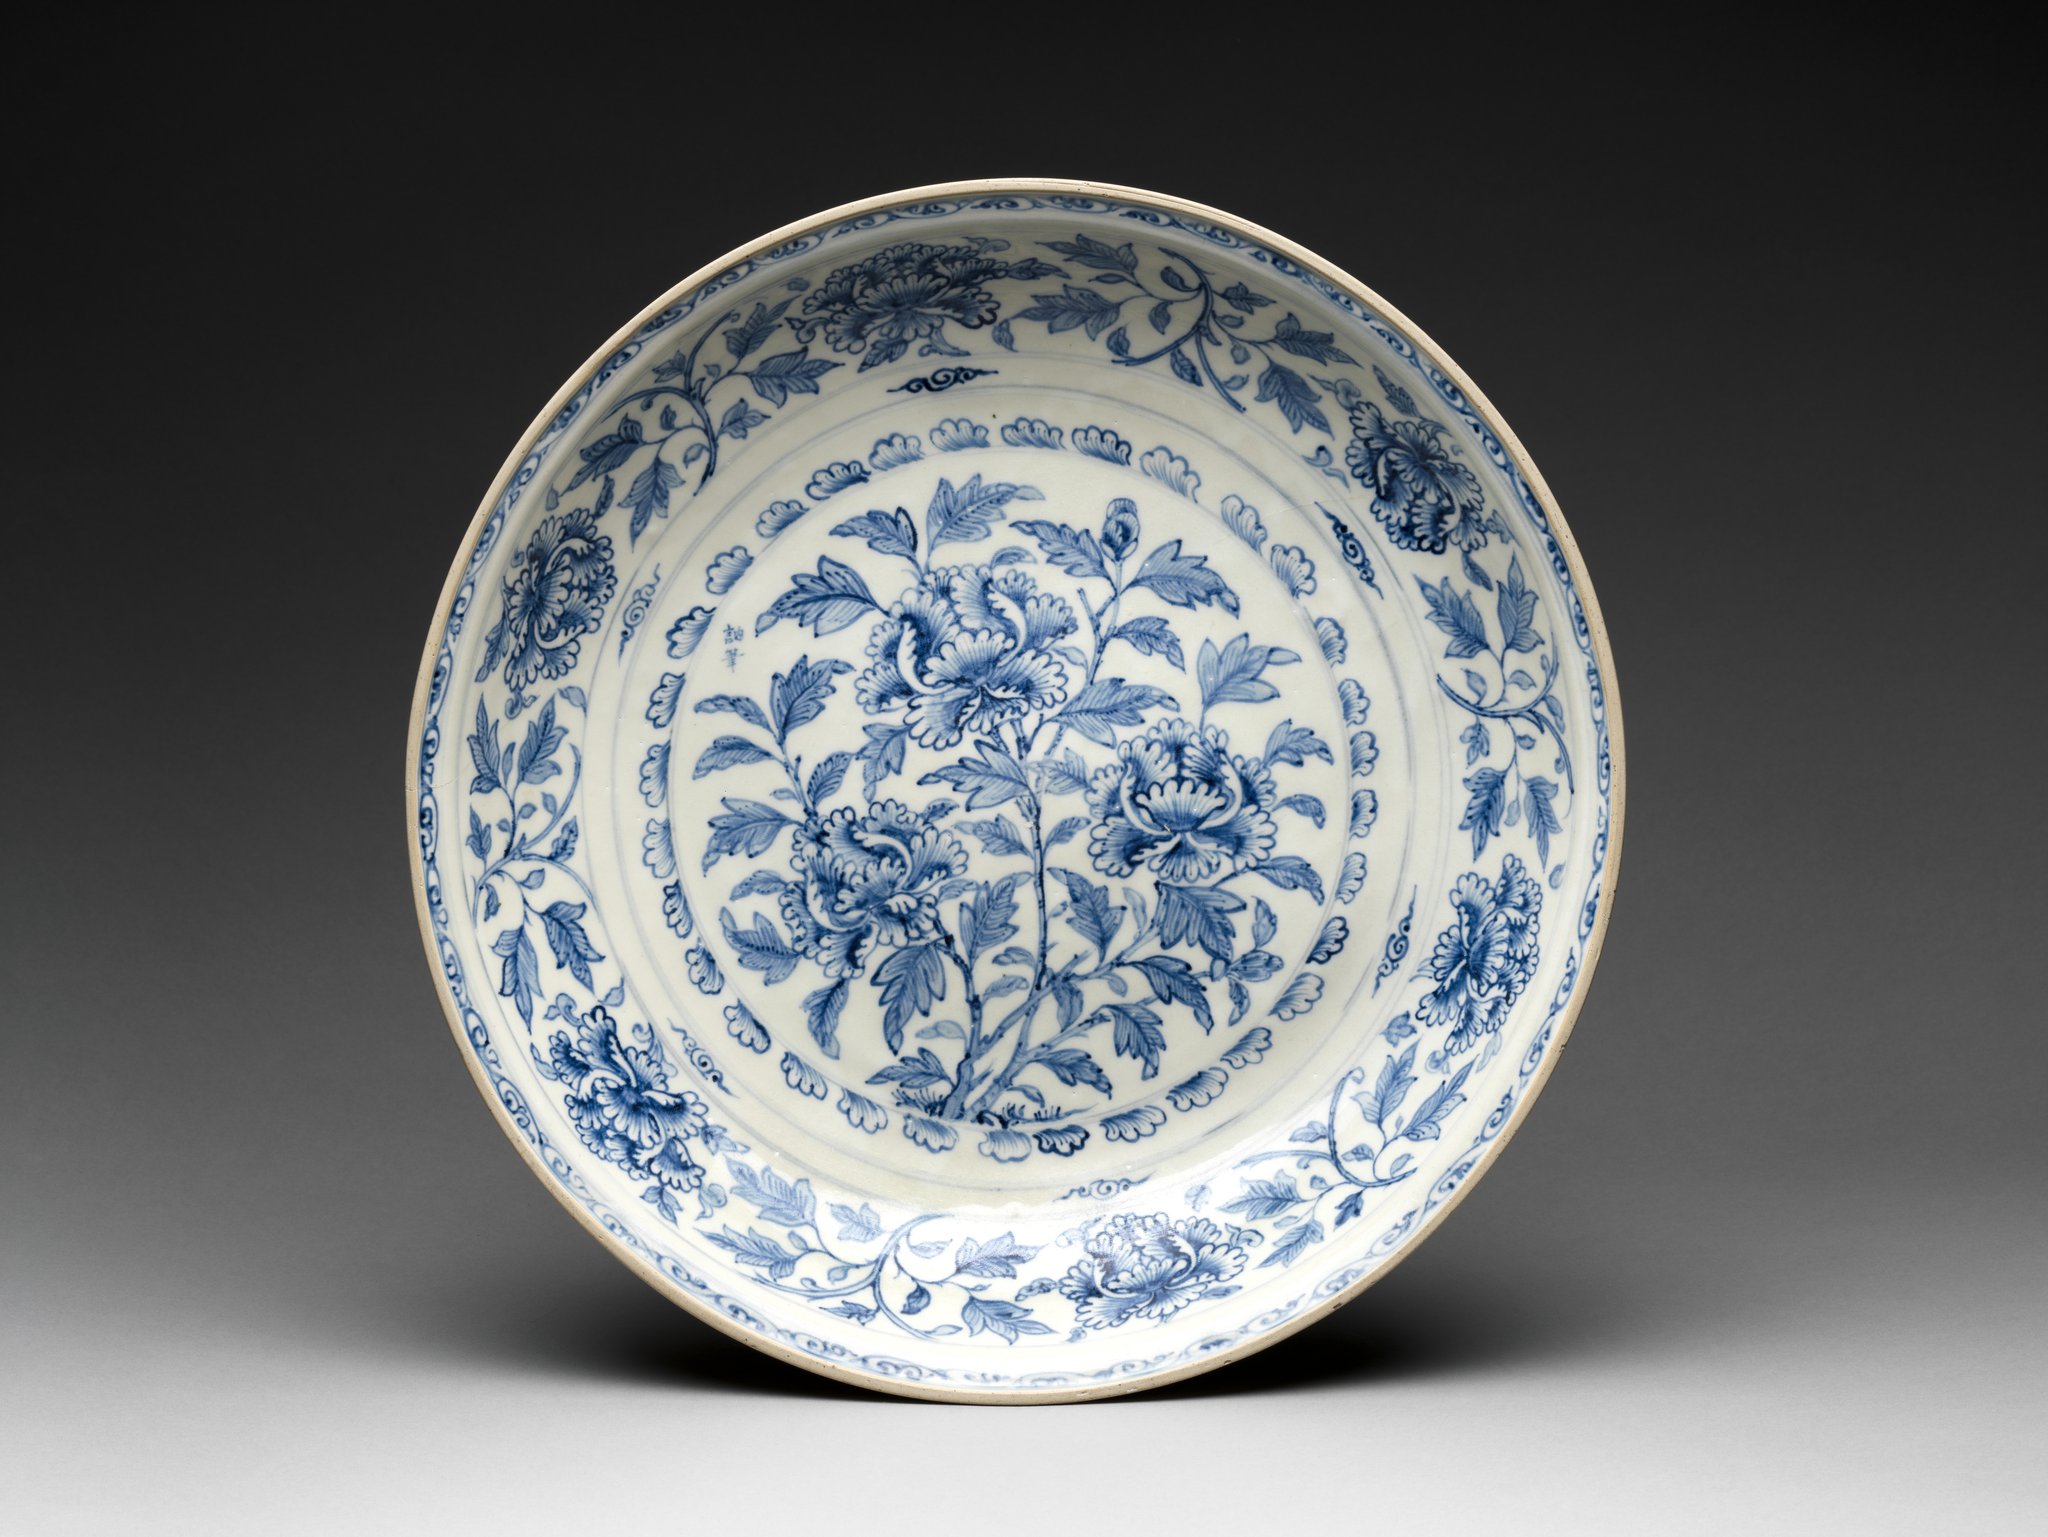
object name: plate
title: Plate with Peonies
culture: vietnamese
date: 1401-1500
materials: cobalt, glaze, stoneware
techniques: painting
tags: peonies